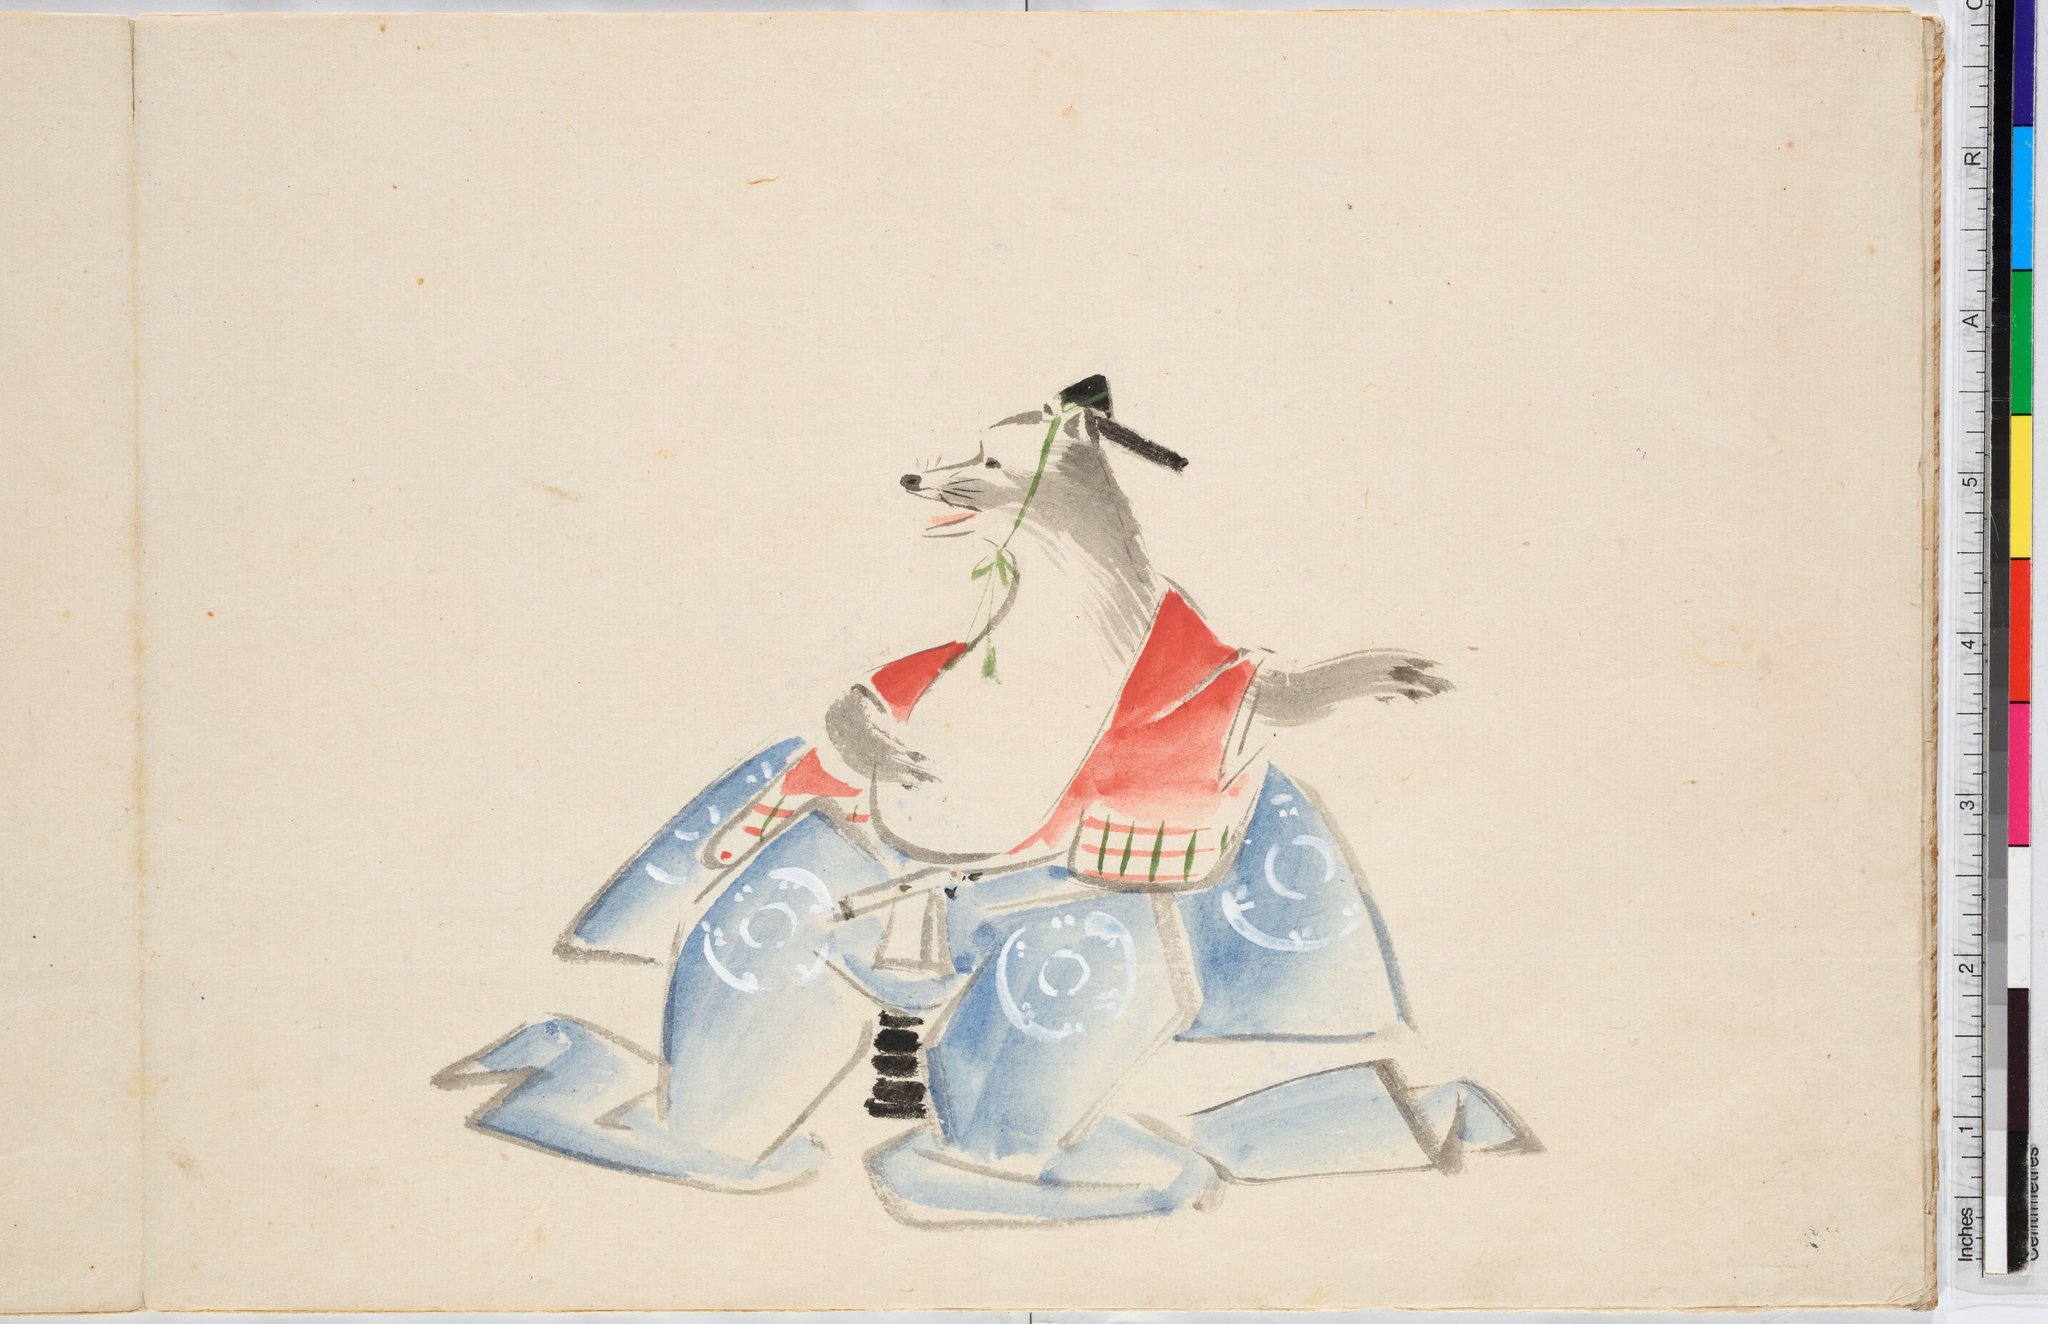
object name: illustrated book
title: Album of Ichiryusai Hiroshige's Sketches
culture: japanese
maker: utagawa hiroshige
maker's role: artist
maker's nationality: japanese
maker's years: 1797-1858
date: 1850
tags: animals